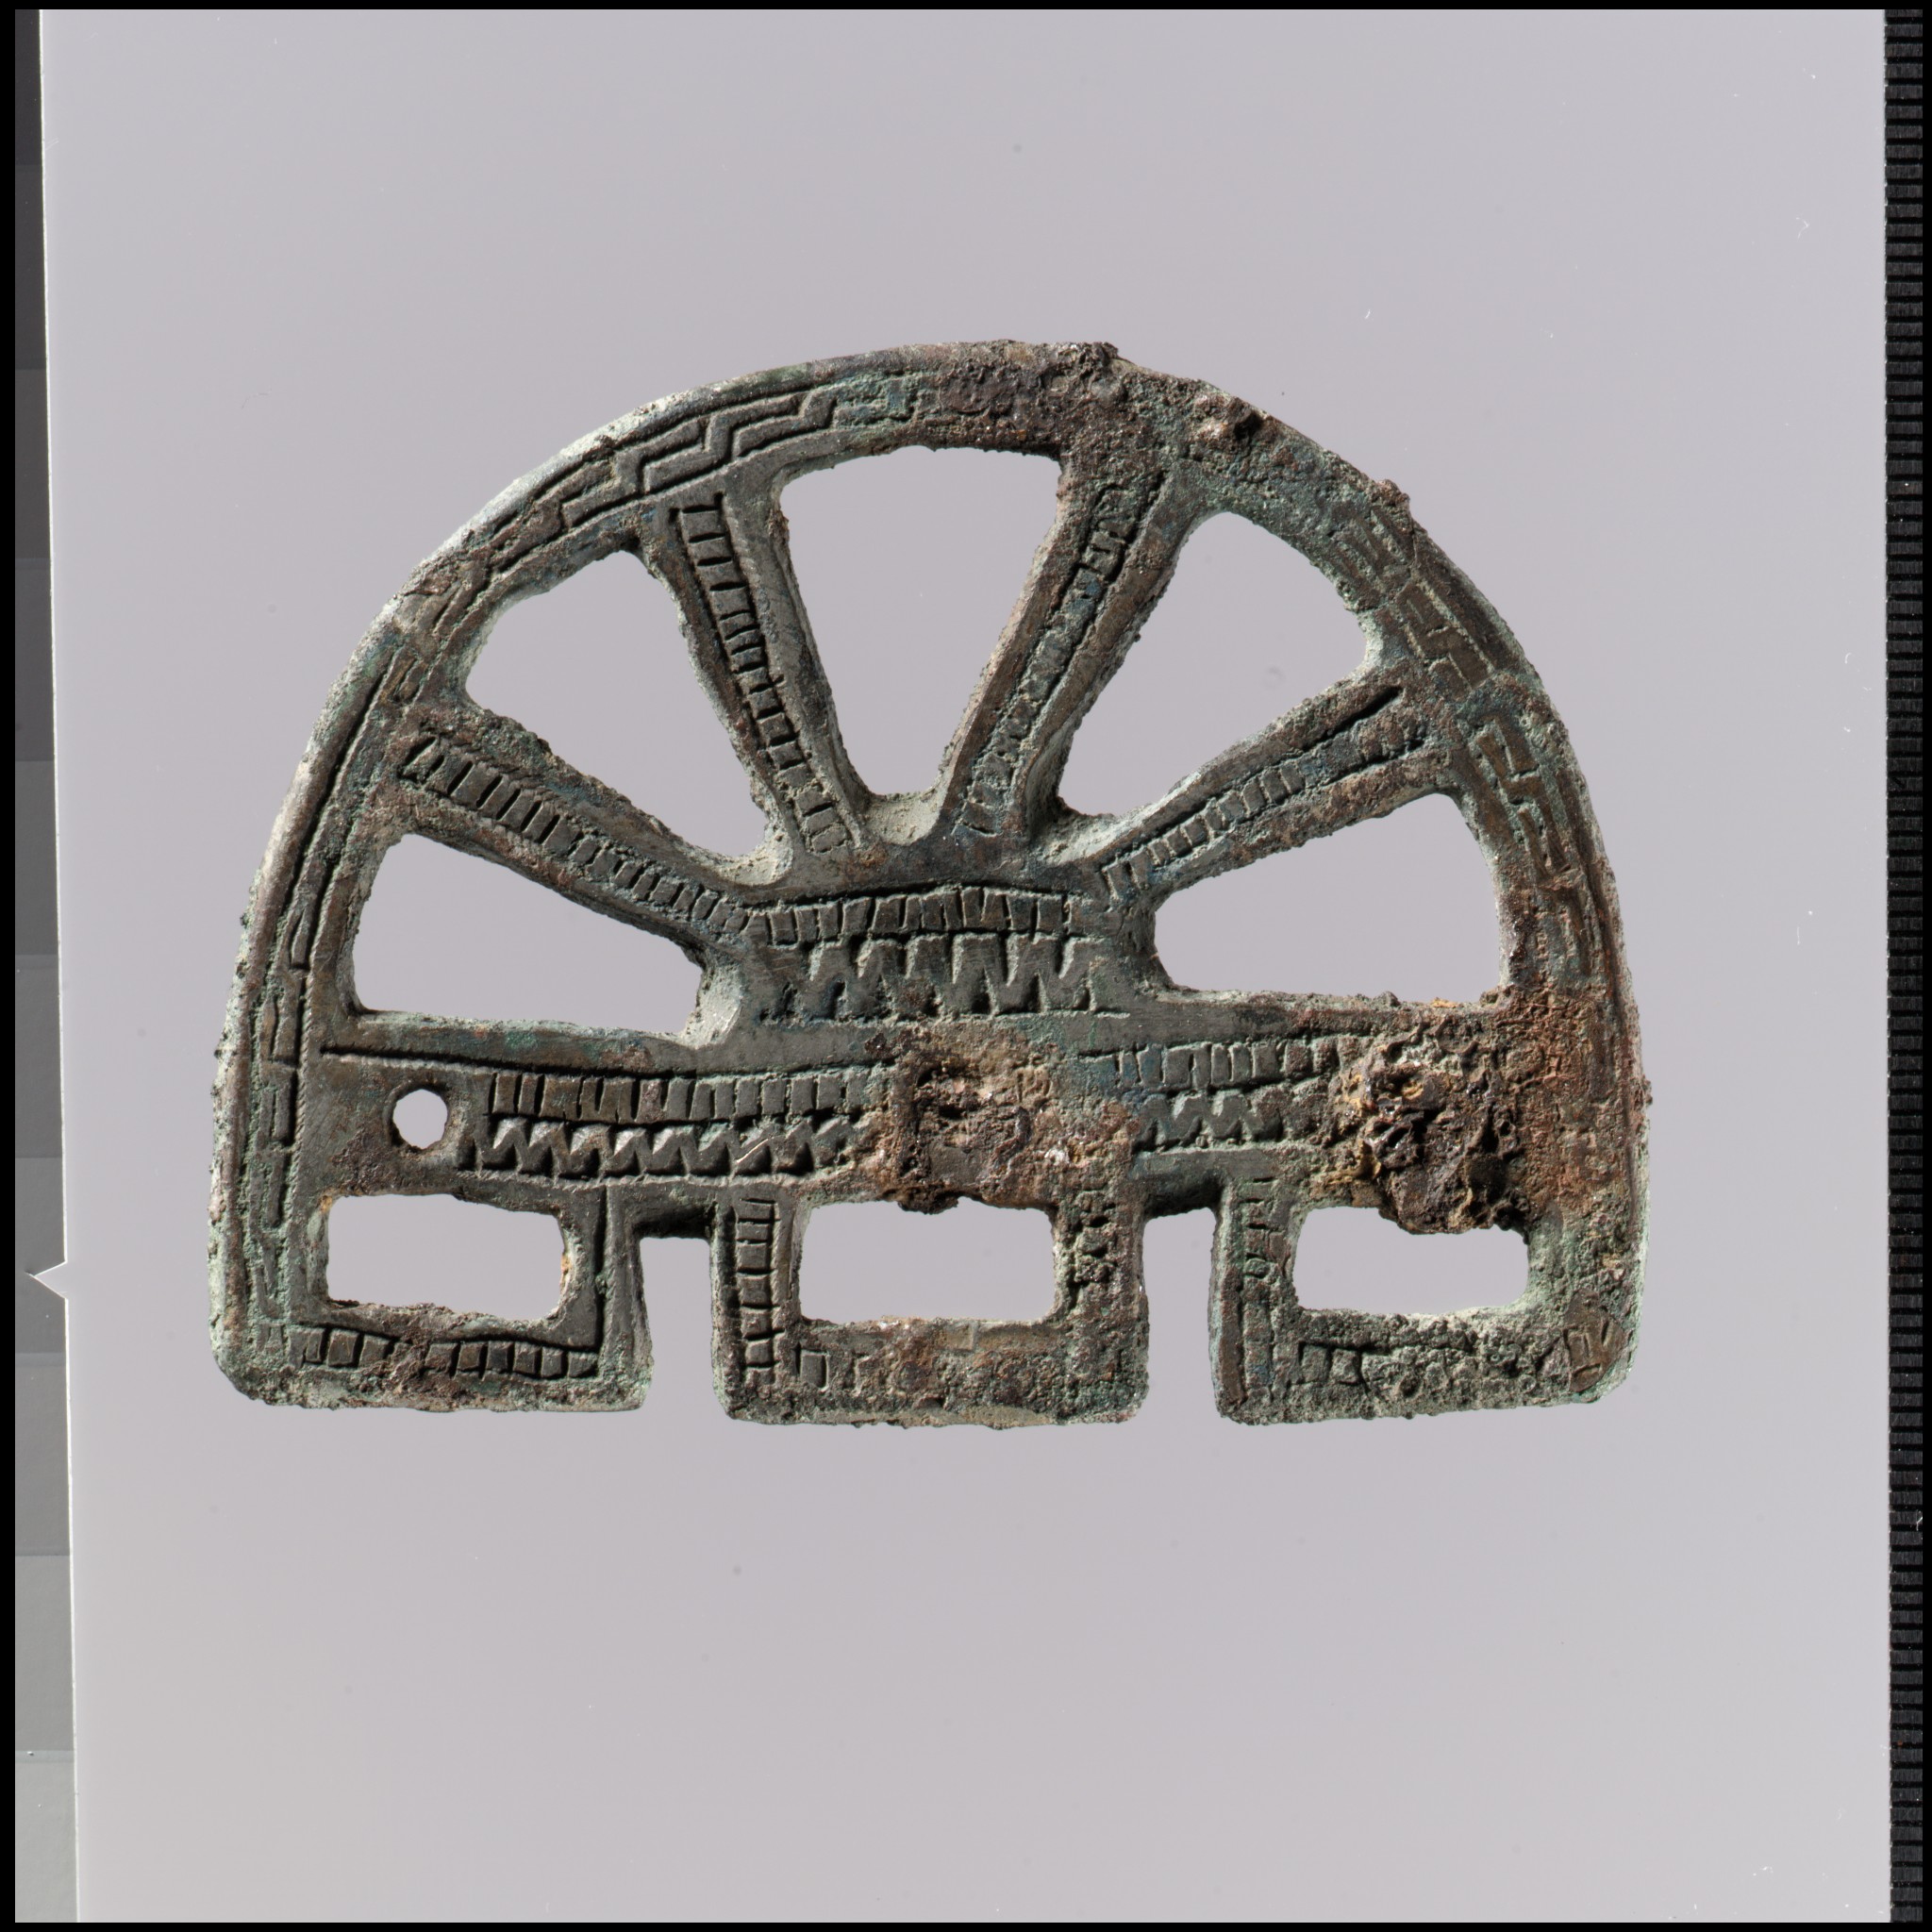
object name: plaque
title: Openwork Plaque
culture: frankish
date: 601-800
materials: copper alloy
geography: france